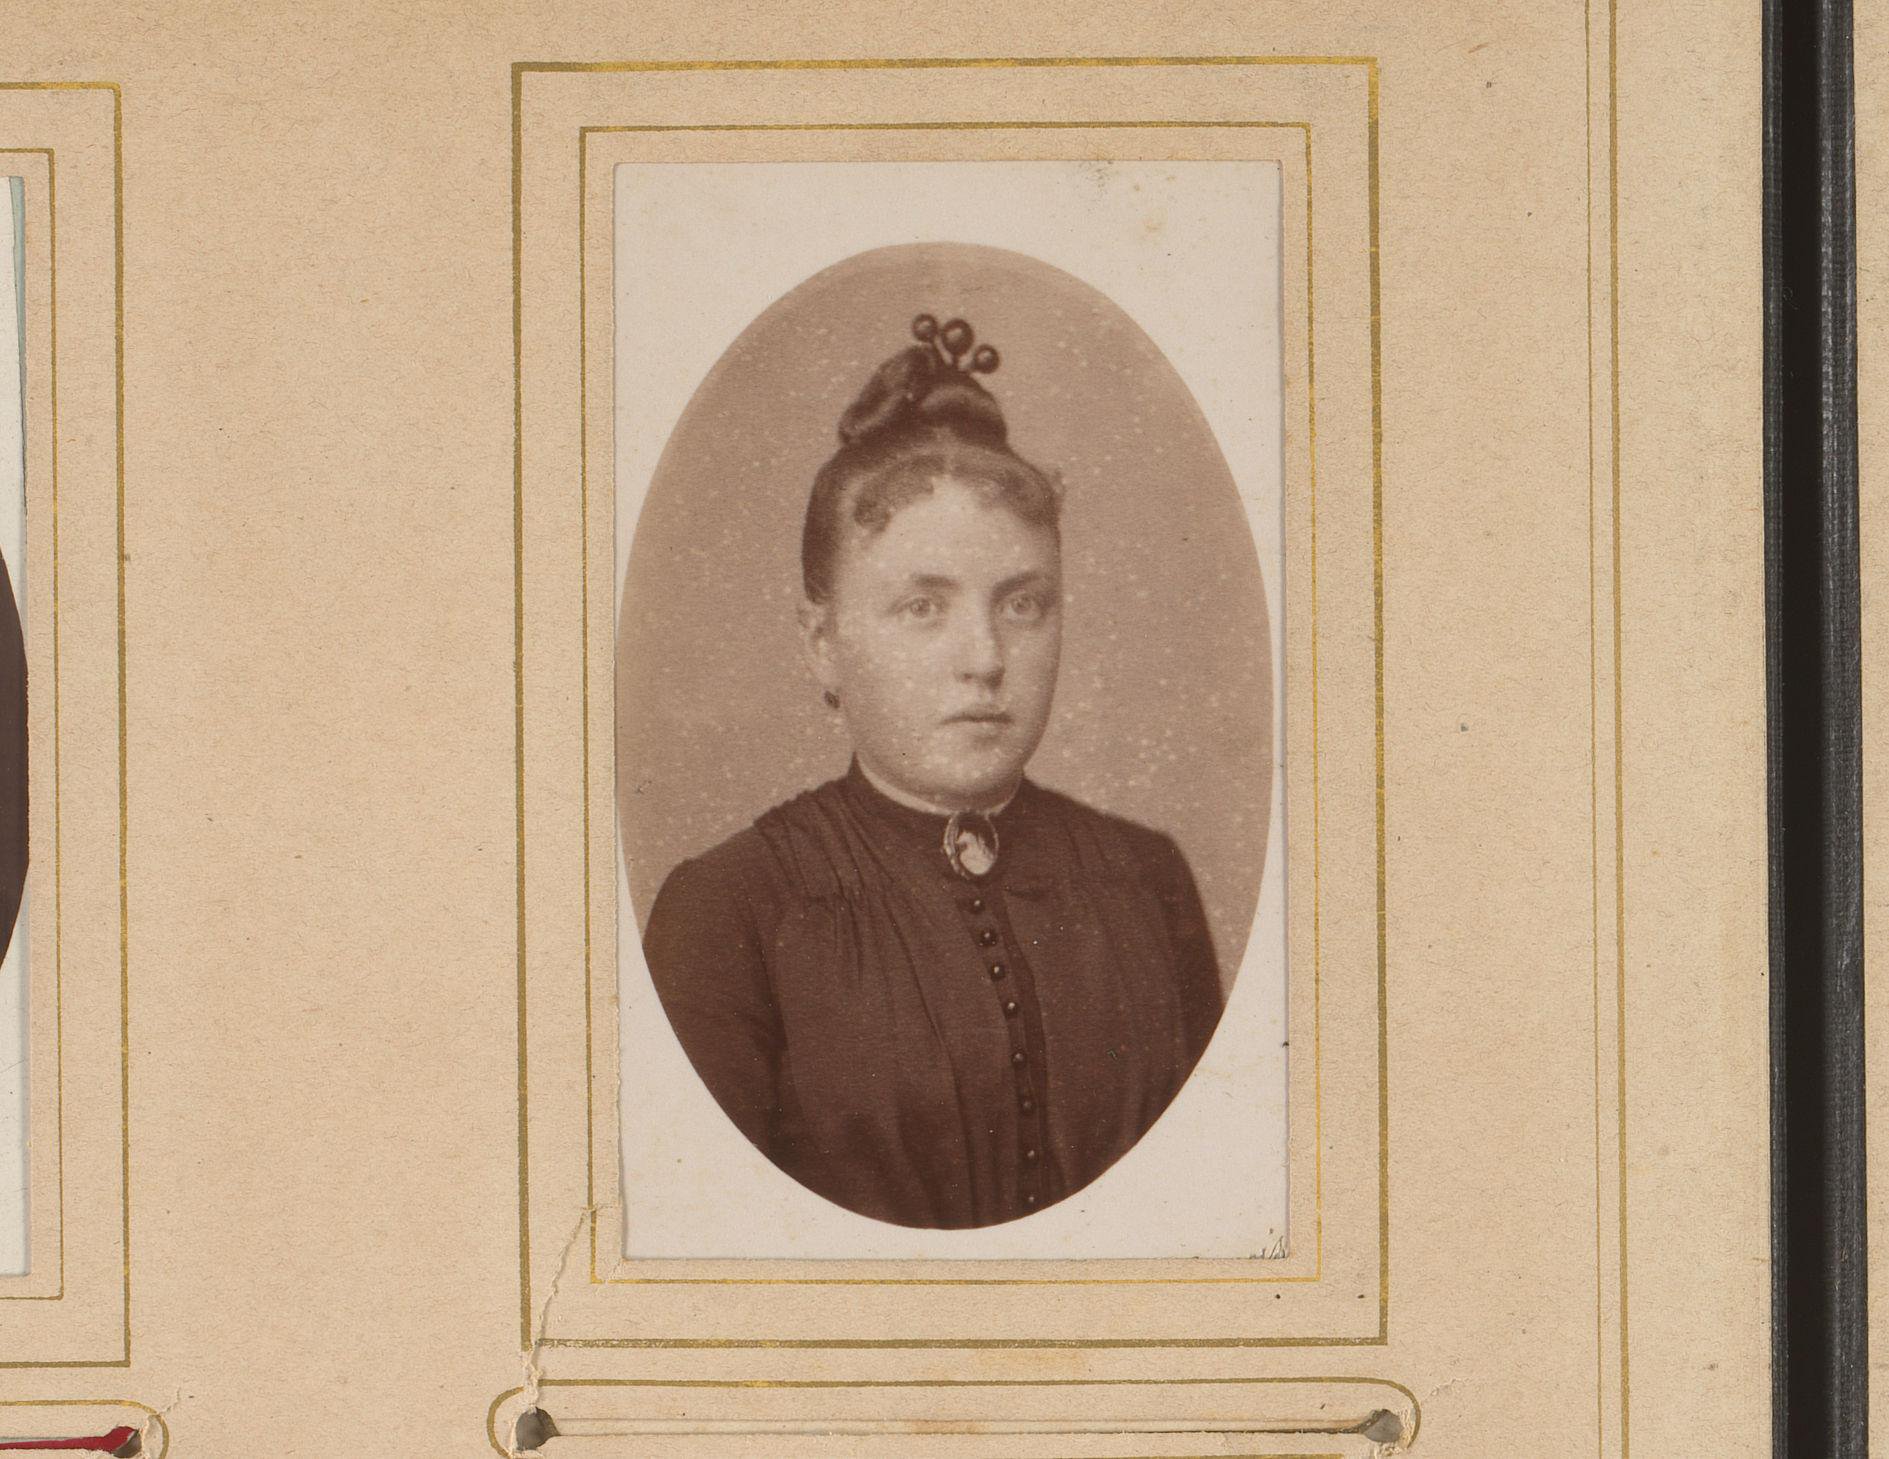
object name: carte de visite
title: Portret van een vrouw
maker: Anonymous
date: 1870-1900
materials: cardboard, photographic support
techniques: albumen print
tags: adult woman, historical persons